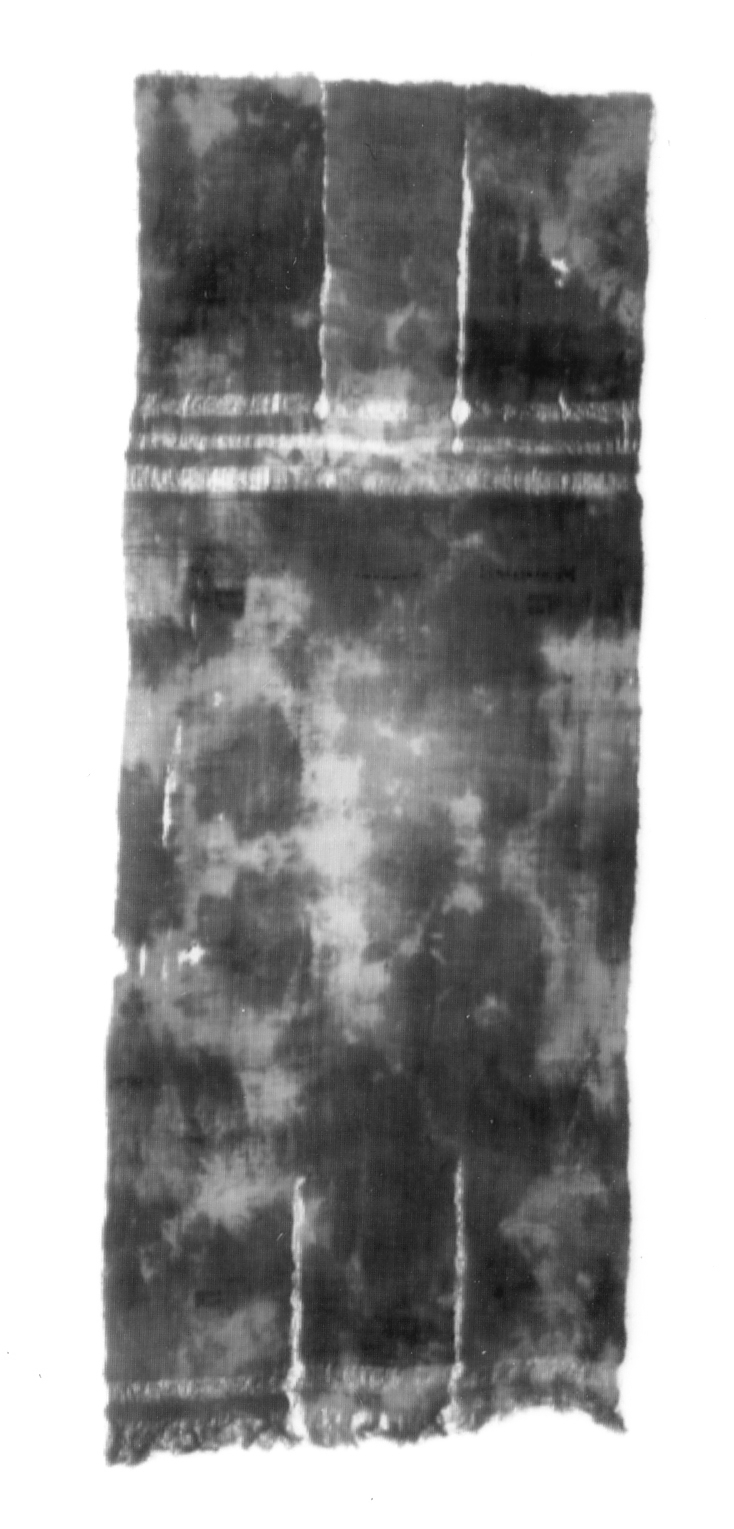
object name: fragment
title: Sheet Fragment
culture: coptic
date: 301-400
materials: linen, wool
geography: egypt